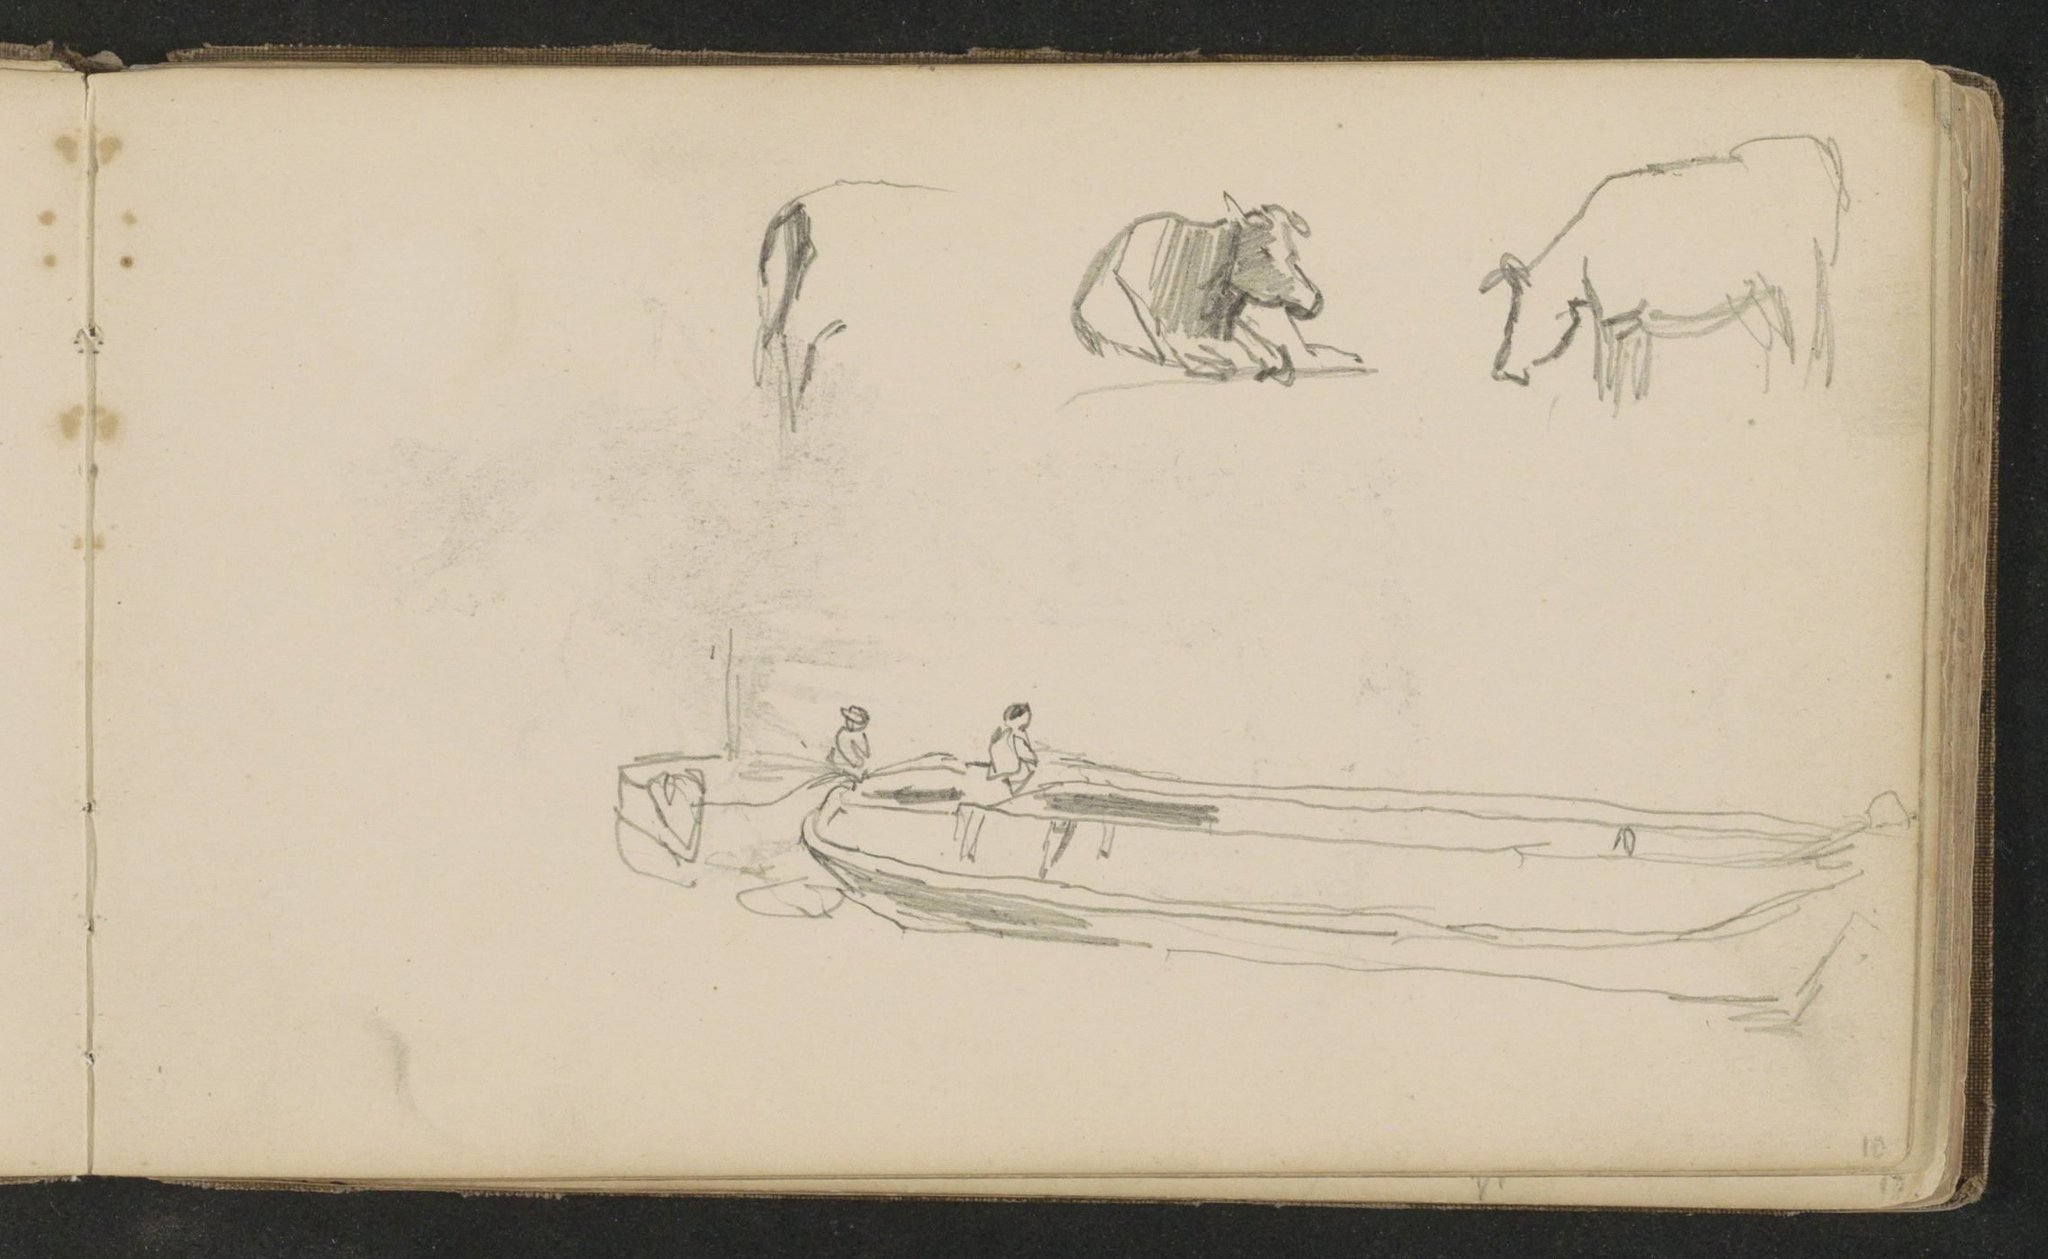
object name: sketchbook leaf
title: Koeien en twee figuren op een schuit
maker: johan hendrik weissenbruch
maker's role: draughtsman, painter, print maker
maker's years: 1824-1903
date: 1834-1903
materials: paper, pencil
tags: cow, boat propelled by man or animal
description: Blad 10 recto uit een schetsboek met 43 bladen.